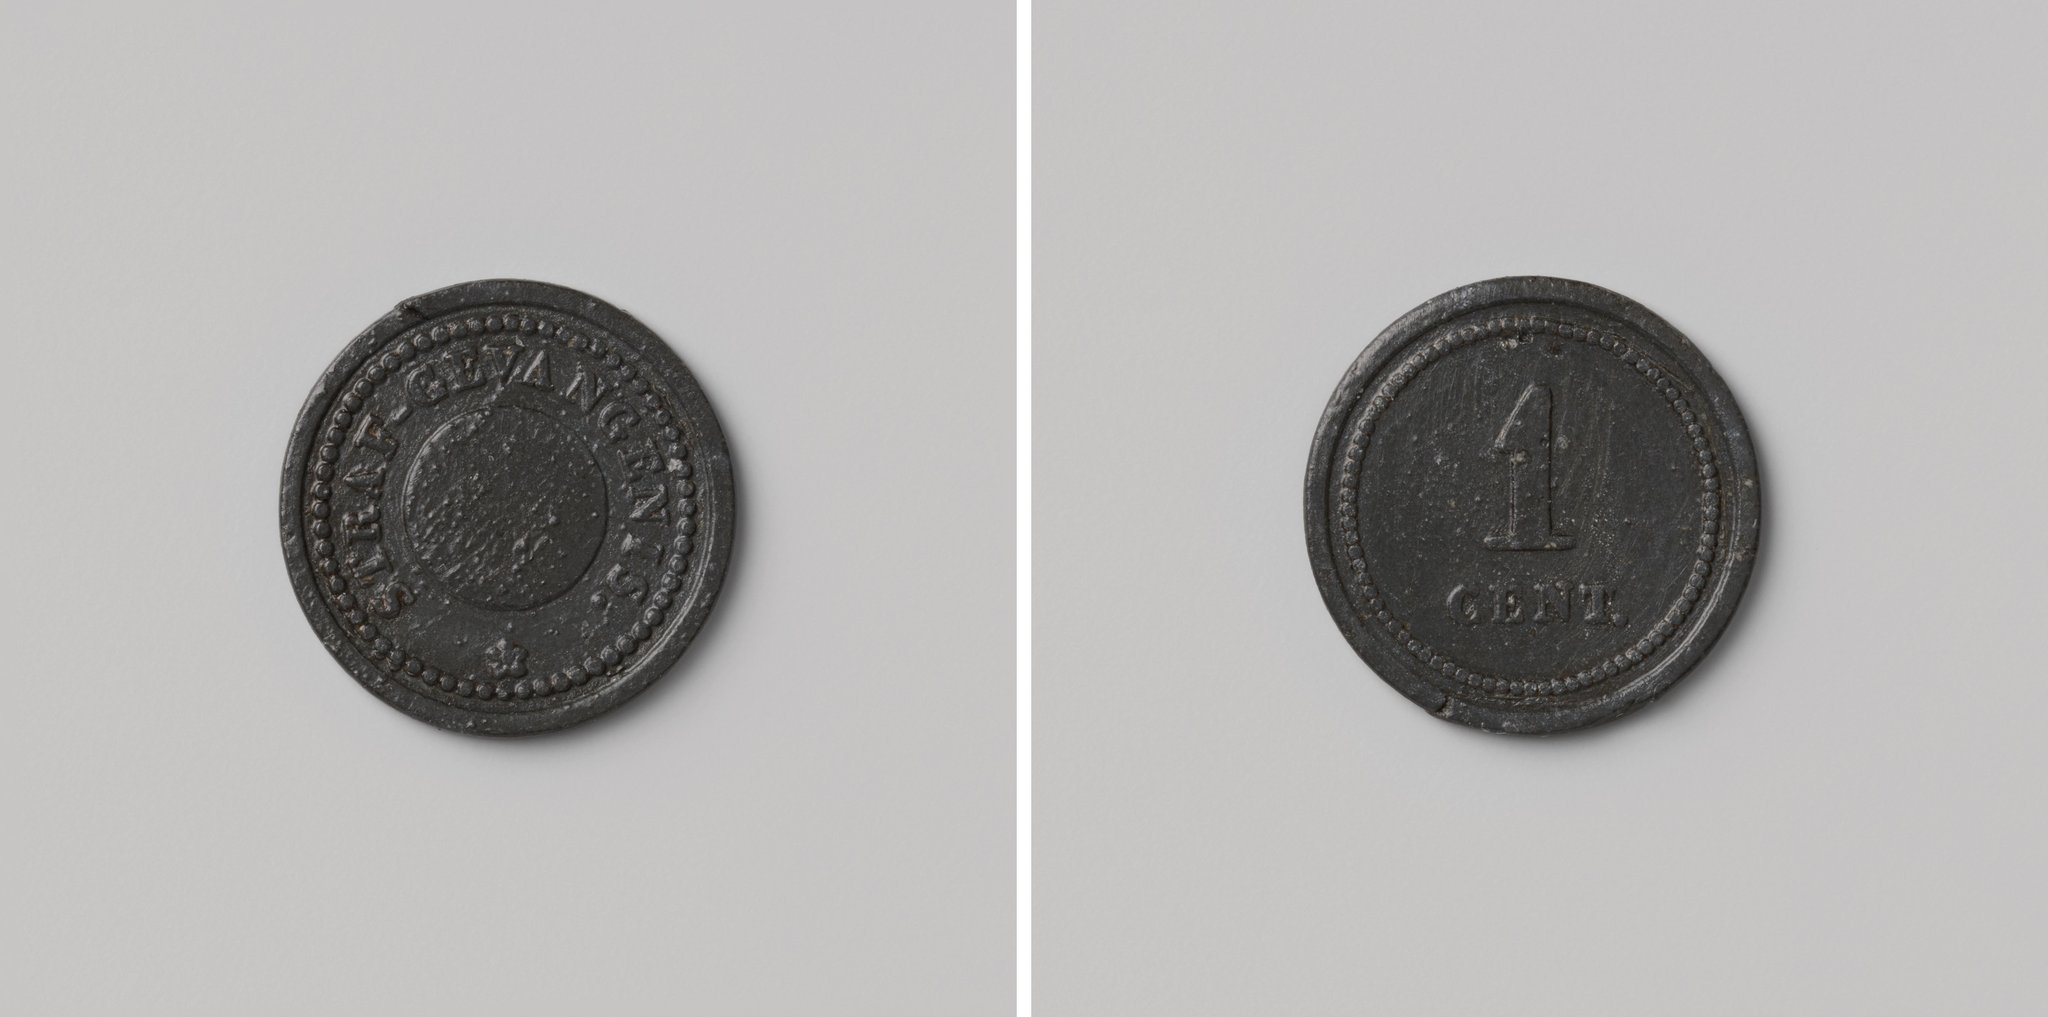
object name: monetary token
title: Huismunt ter waarde van een cent van de strafgevangenis te Woerden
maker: Anonymous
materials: zinc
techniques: striking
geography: utrecht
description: Zinken betaalpenning. Voorzijde: leeg veld binnen omschrift. Keerzijde: waardeaanduiding